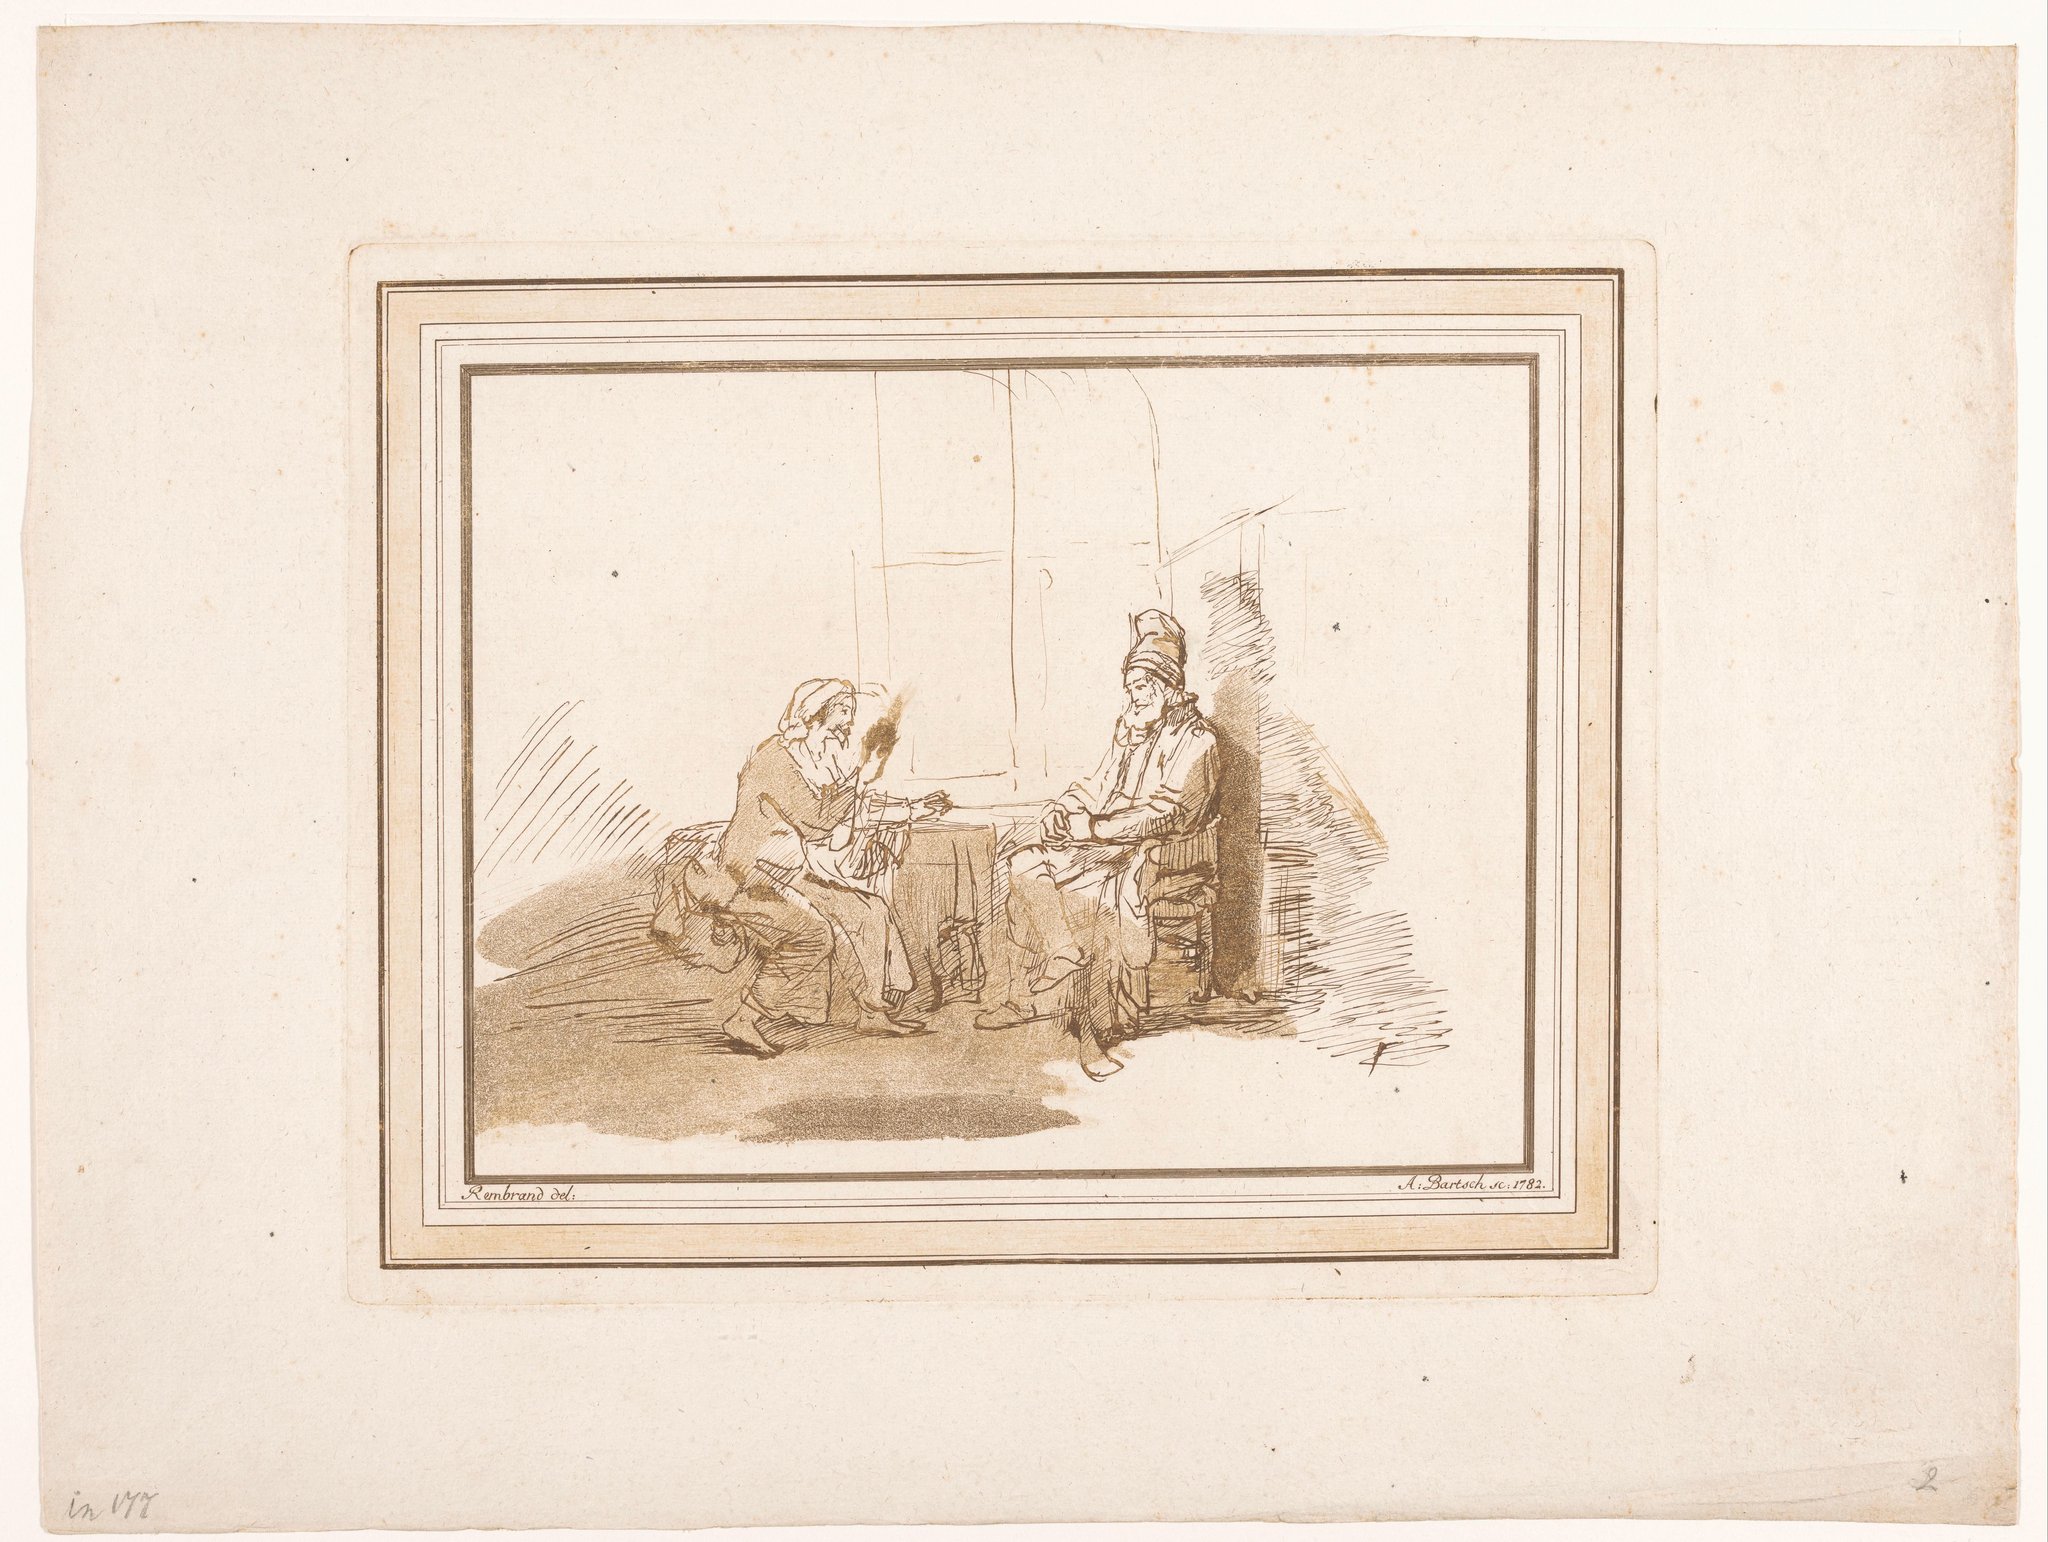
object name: print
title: Christus in gesprek met Nikodemus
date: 1782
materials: paper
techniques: aquatint, etching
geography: netherlands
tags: christ talking with nicodemus at night (john 3:1-21)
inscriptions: collector's mark: Lugt 240